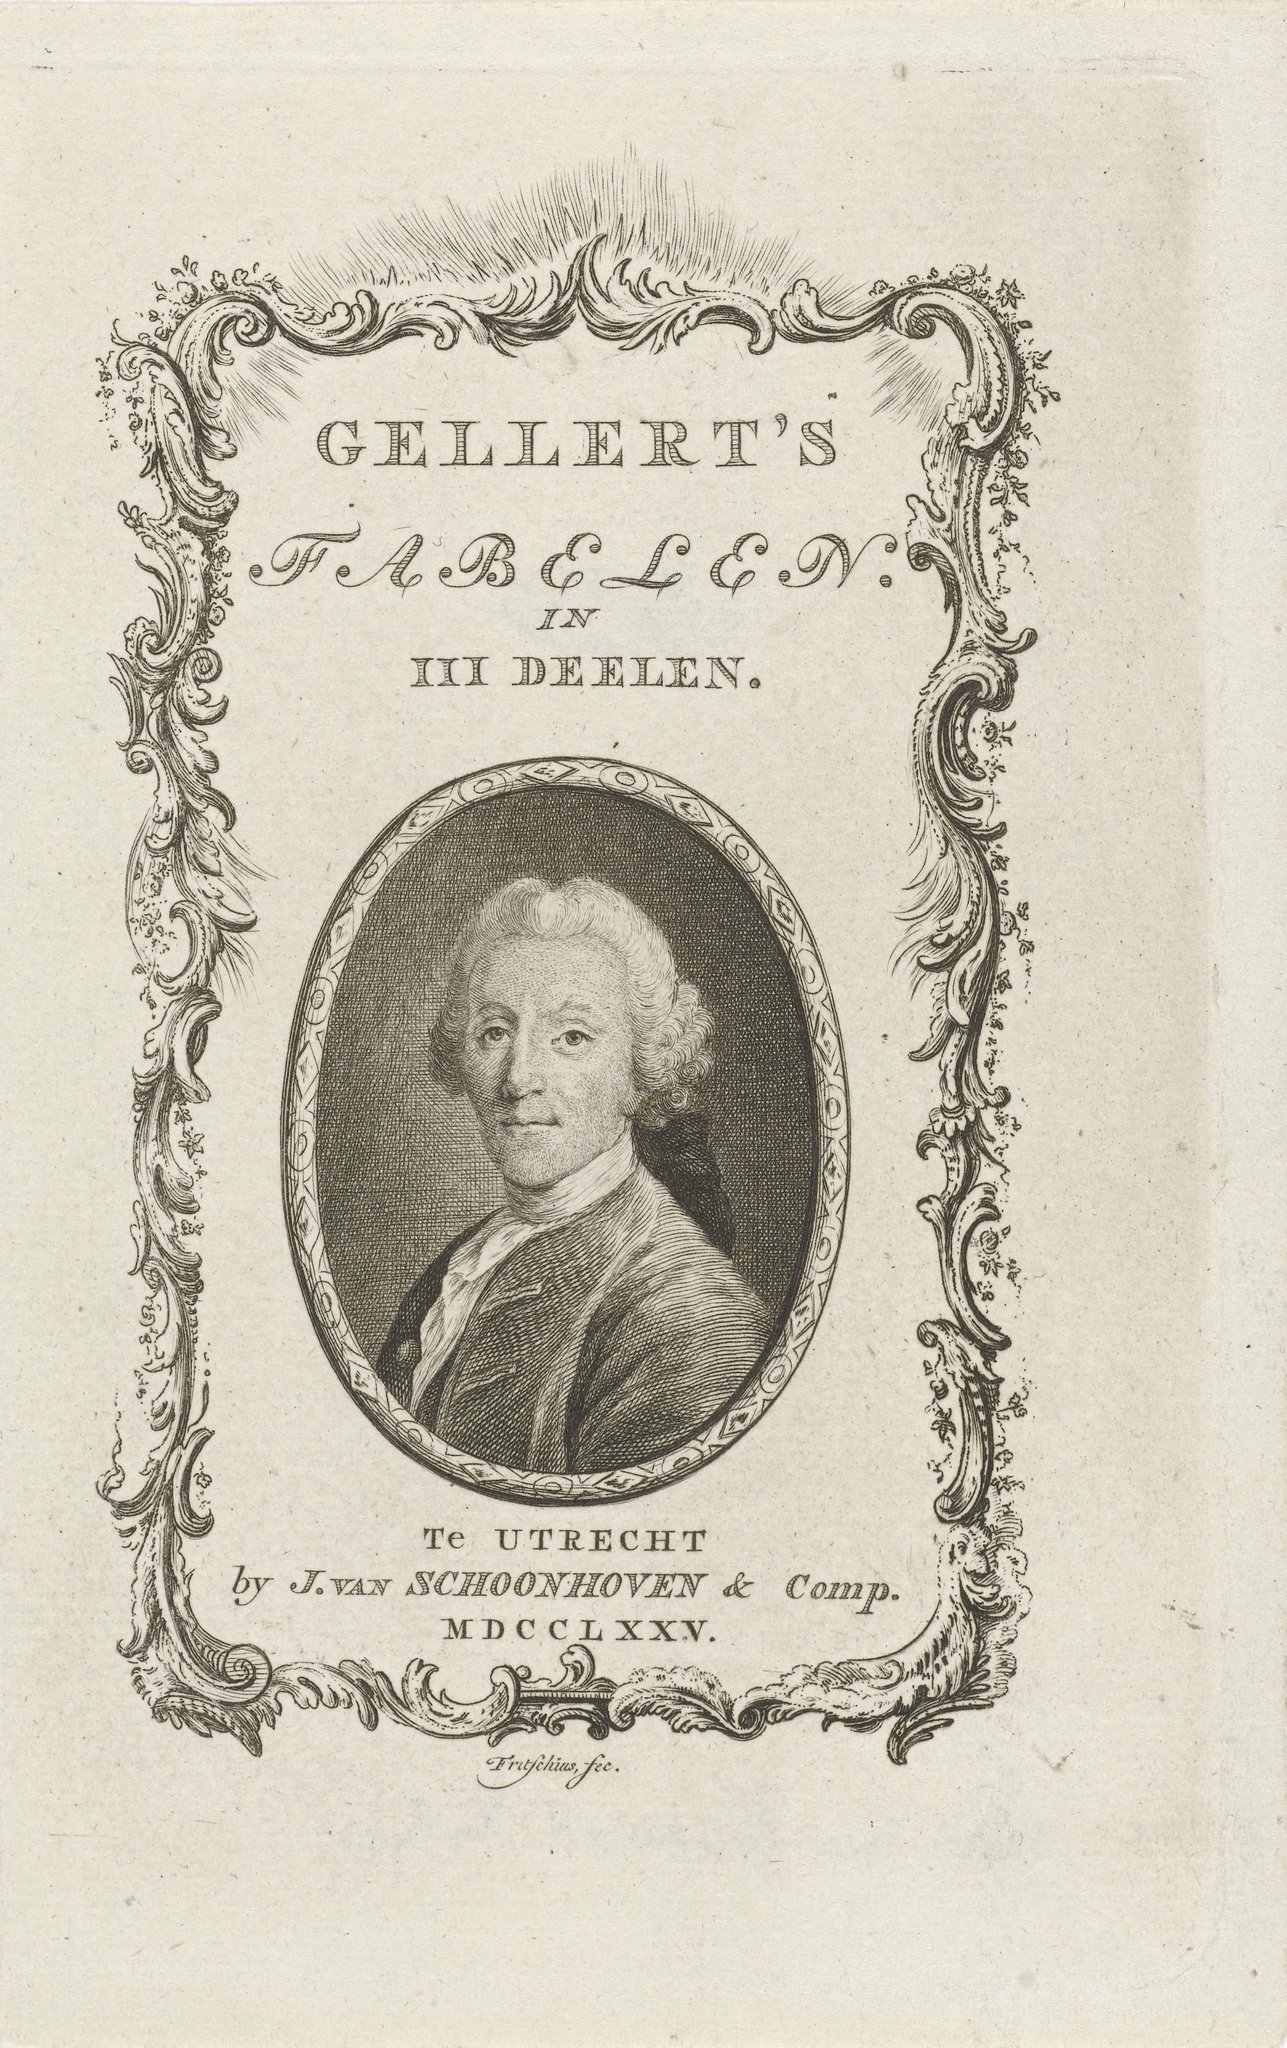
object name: print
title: Portret van Christian Furchtegott Gellert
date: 1775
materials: paper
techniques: etching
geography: utrecht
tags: saksen, dichter, christian fürchtegott gellert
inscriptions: collector's mark: Lugt 2228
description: Portretbuste in ovaal naar links van de auteur Christian Furchtegott Gellert, met staartpruik. Boven het ovaal staat de titel, eronder het uitgeversadres. Het geheel is omkaderd met een ornamentele lijst.